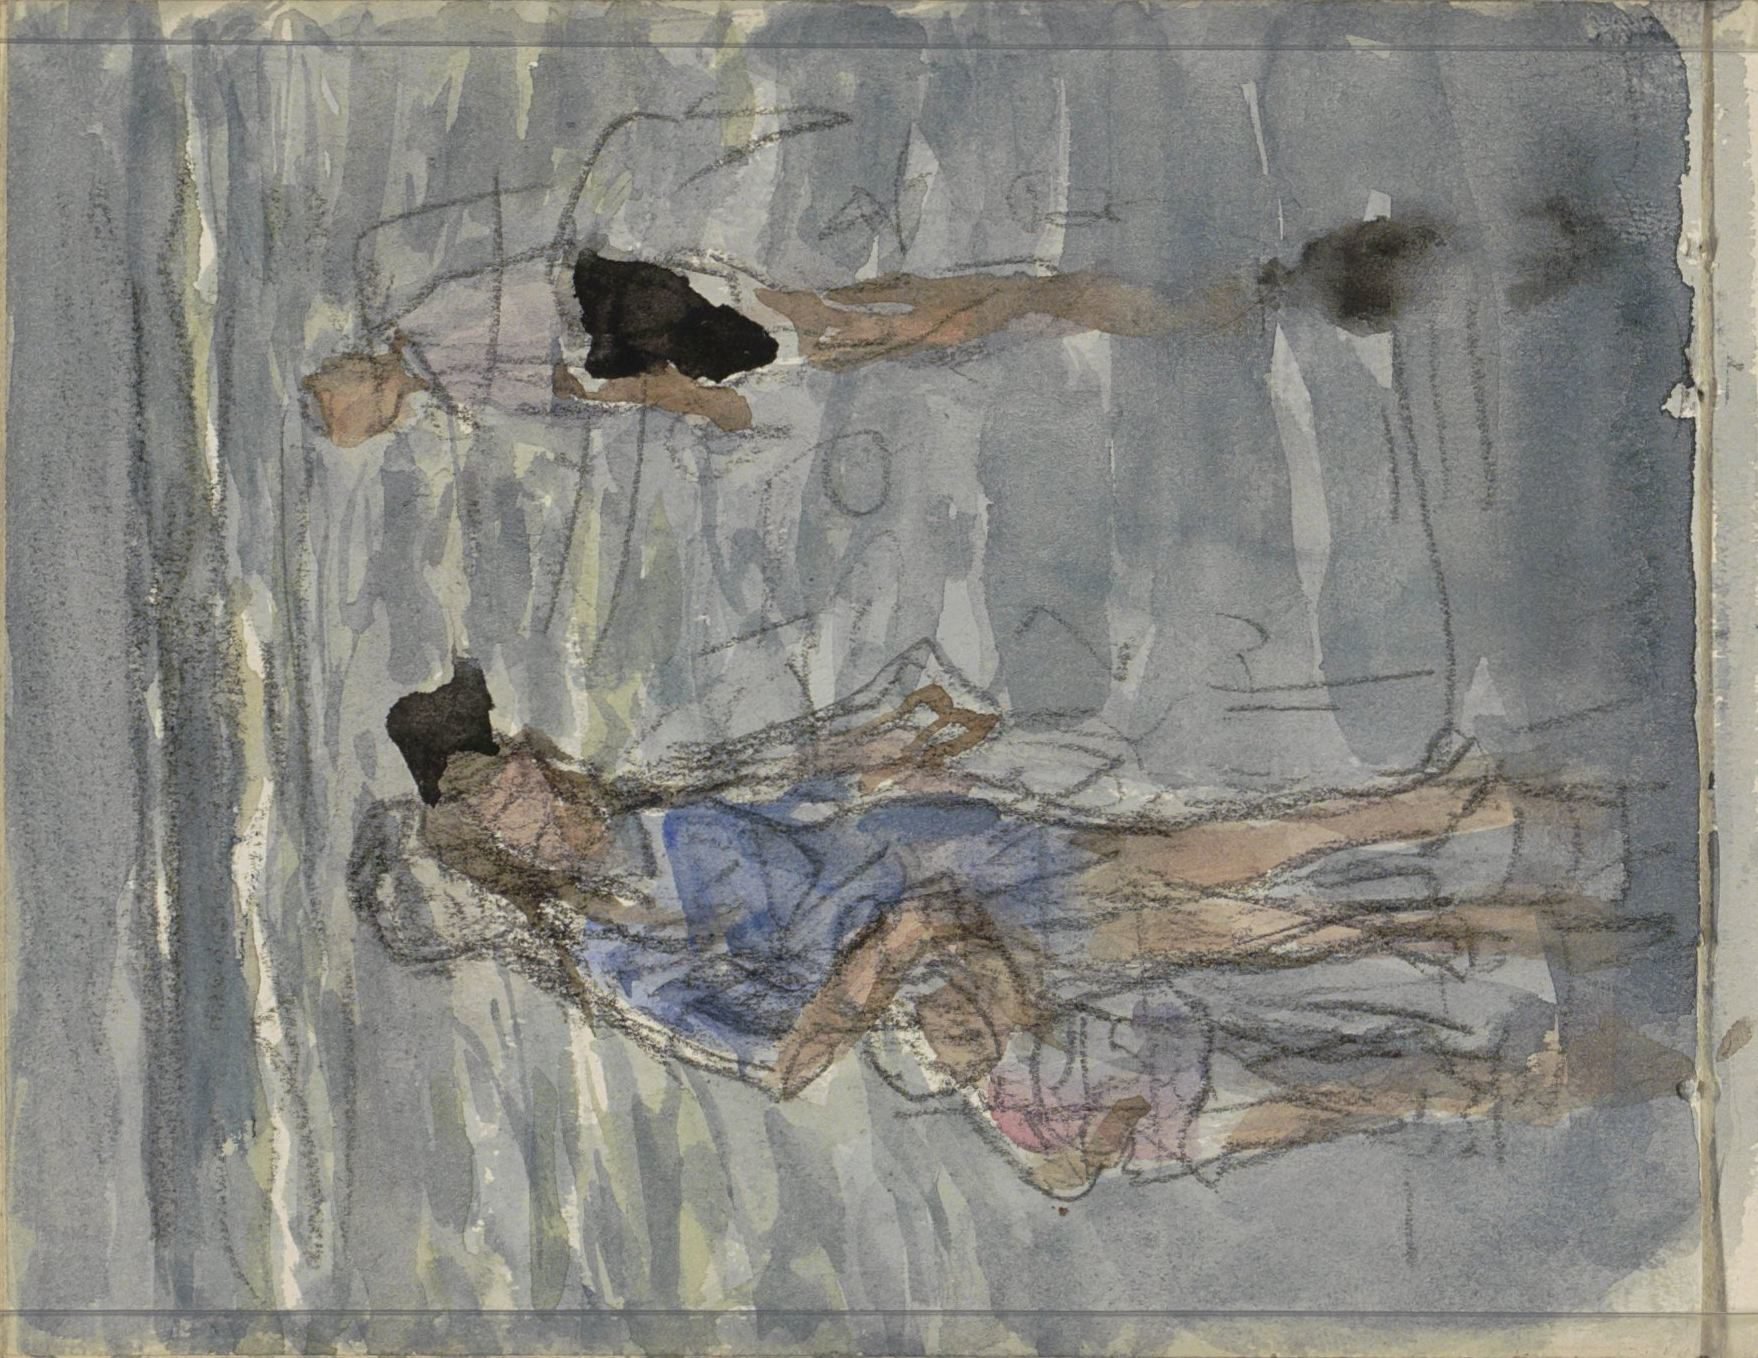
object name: sketchbook leaf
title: Figuren in zee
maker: johan antonie de jonge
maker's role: draughtsman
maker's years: 1864-1927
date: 1881-1927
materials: chalk, paper, watercolor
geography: south holland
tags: mother and child(ren), woman and child(ren) (family group), in or beside the water (on the beach)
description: Figuren in zee. Blad 13 verso uit een schetsboek met 29 bladen.